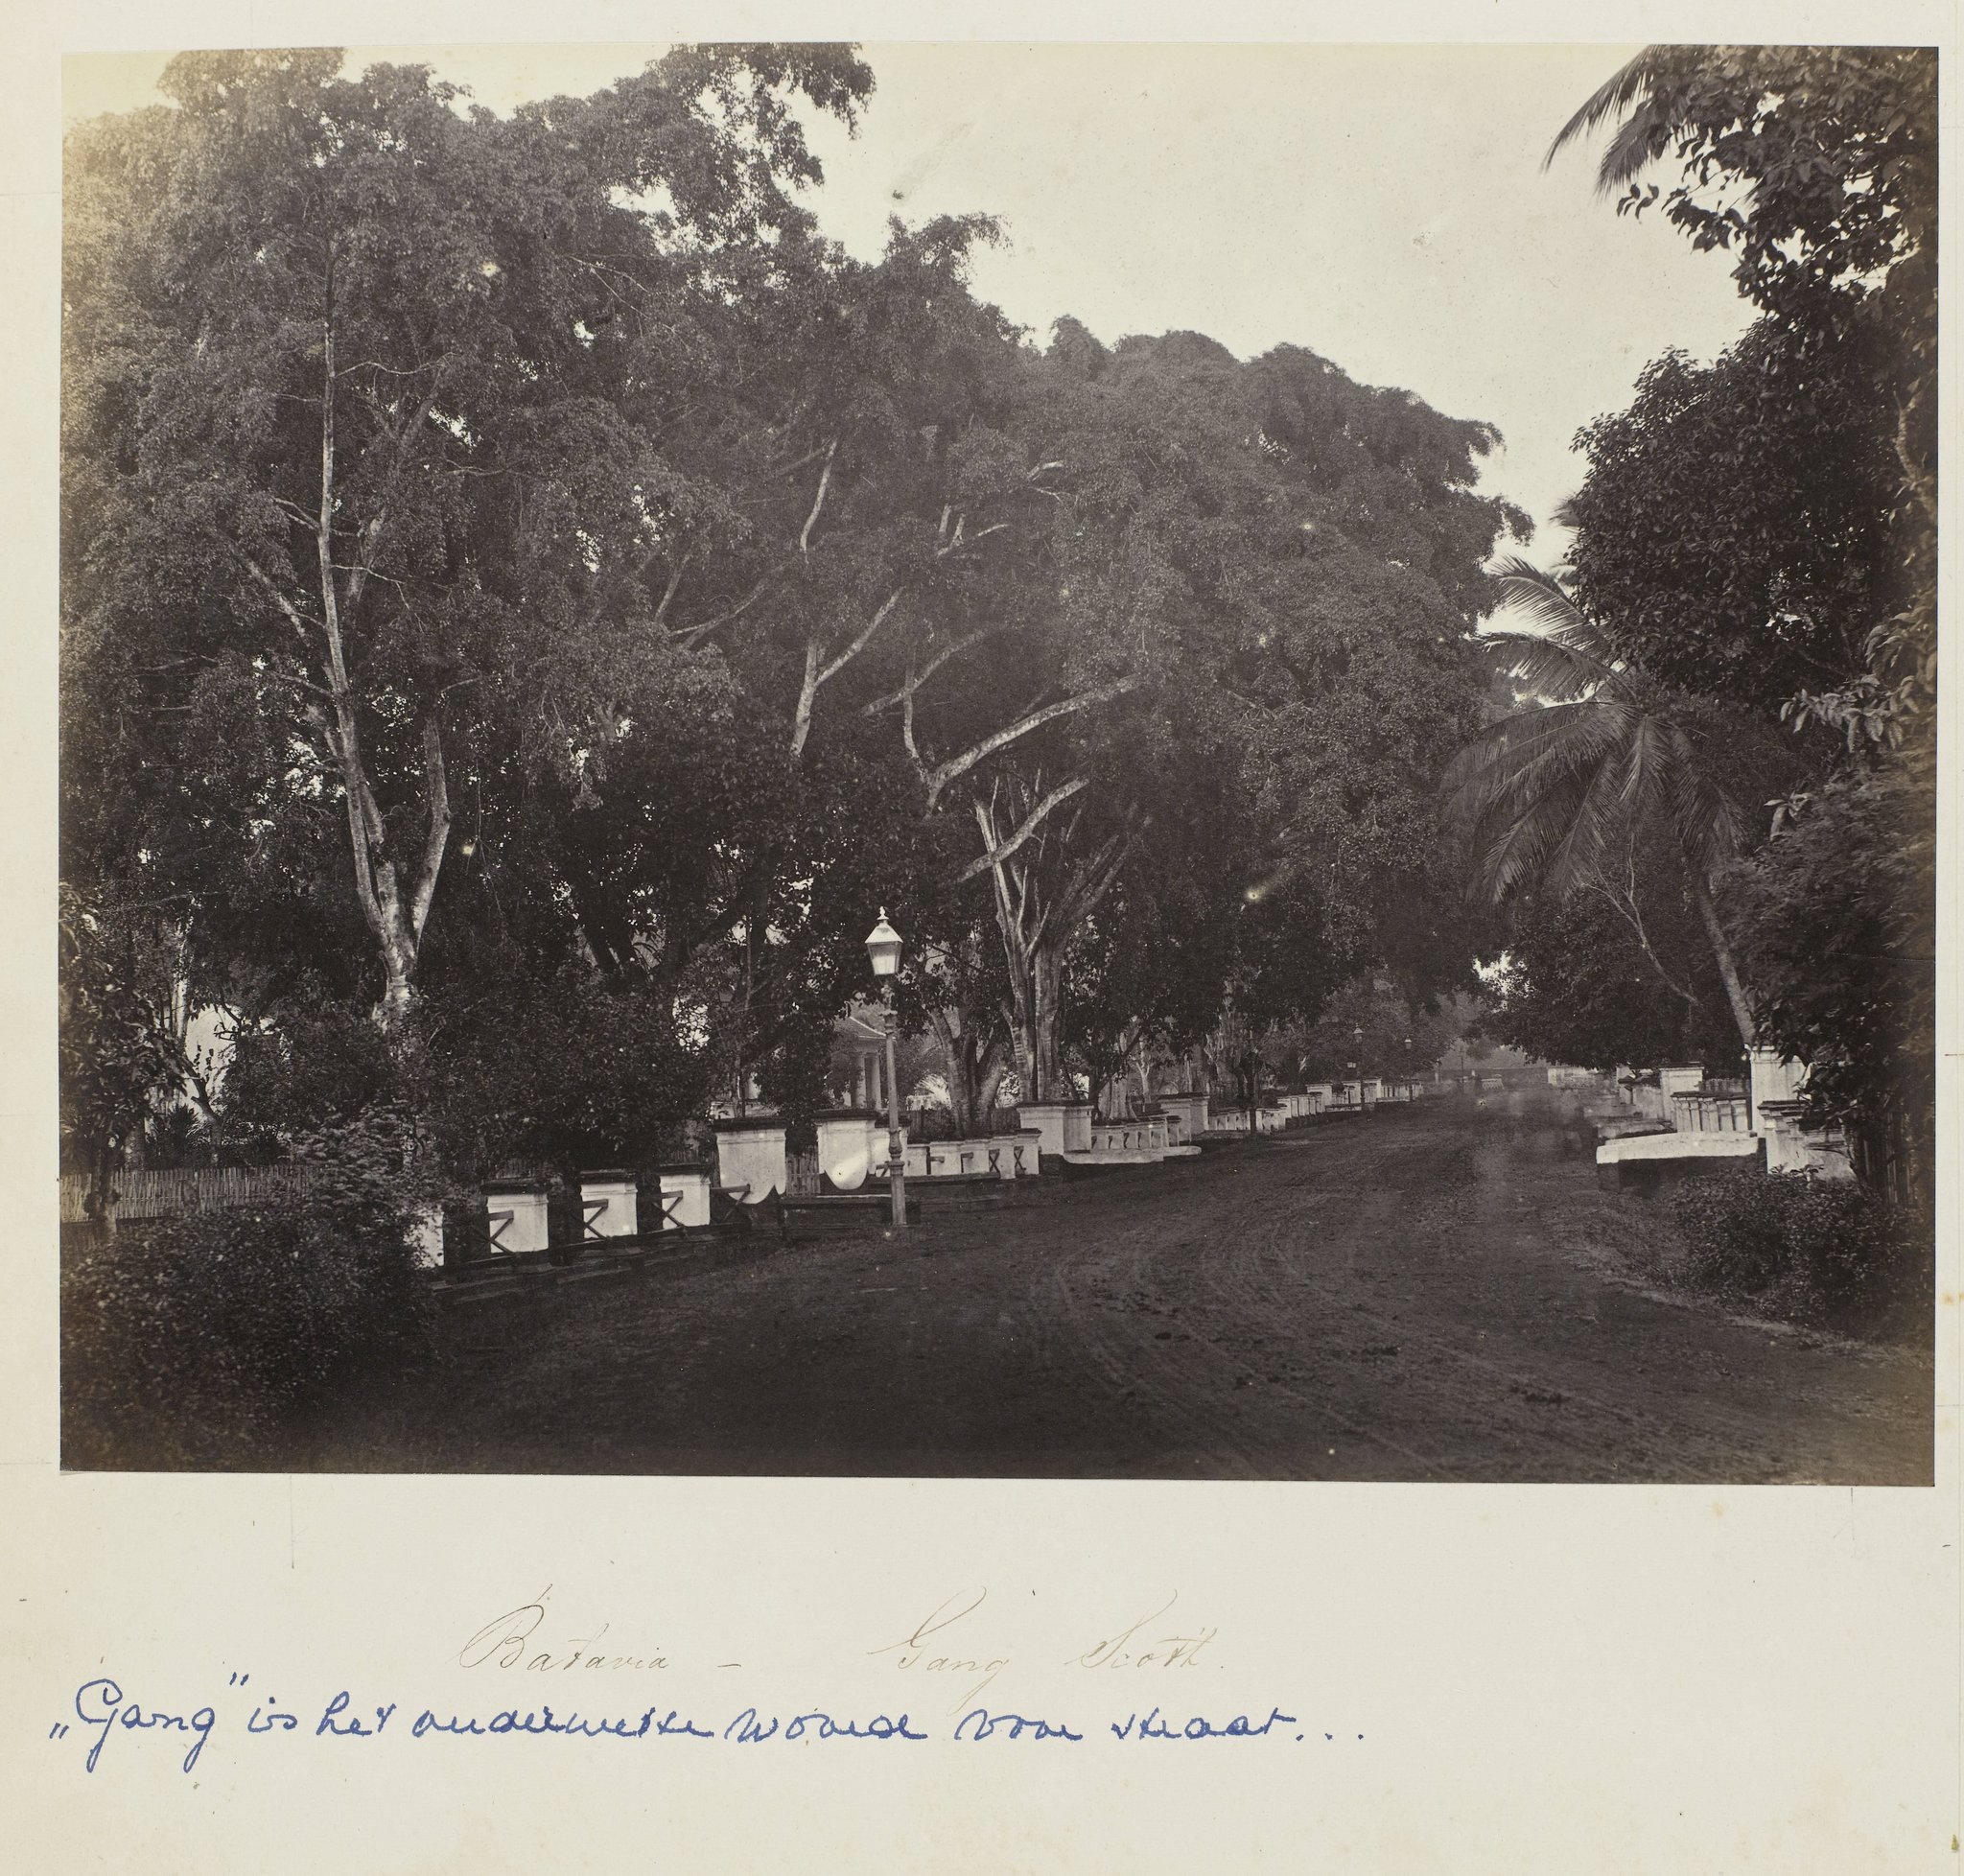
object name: photograph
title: Batavia - Gang Scott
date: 1863-1866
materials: photographic support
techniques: albumen print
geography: batavia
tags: street, batavia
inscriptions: inscription: ‘"Gang" is het ouderwetse woord voor straat ...’, inscription: ‘Batavia - Gang Scott’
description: Gezicht in de Gang Scott in Batavia. Onderdeel van het rode fotoalbum met foto's van Java, uit het bezit van apotheker Specht-Grijp, die in 1865 vanuit Batavia naar Nederland terugkeerde.